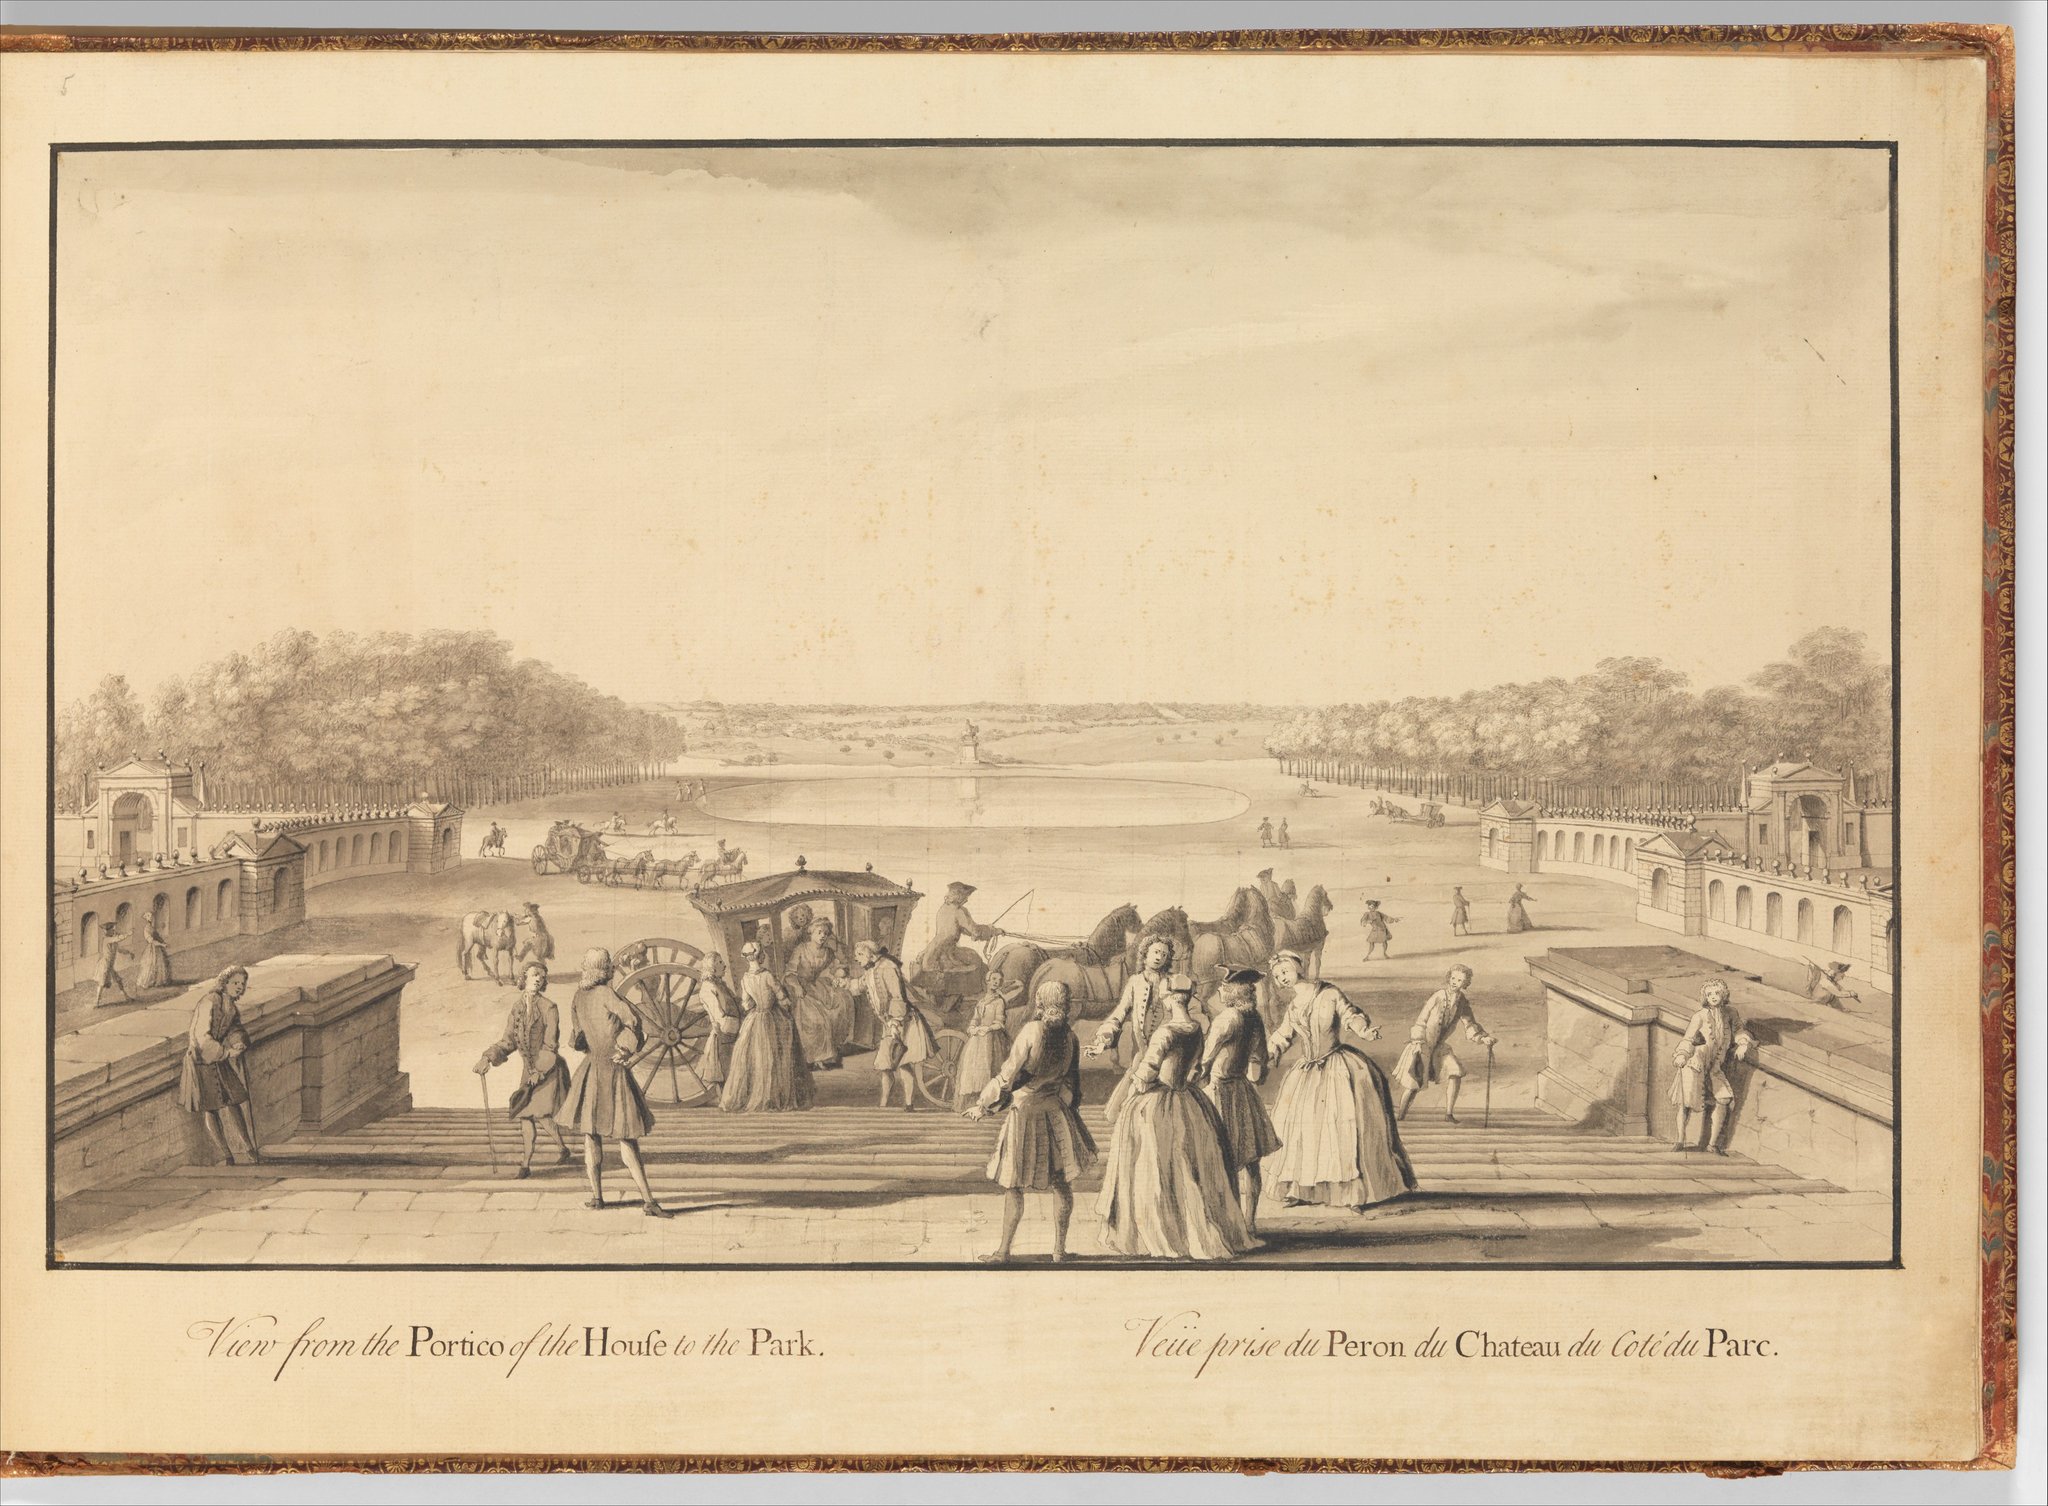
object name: drawing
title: View from the Portico of the House to the Park at Stowe, Buckinghamshire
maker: jacques rigaud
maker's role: artist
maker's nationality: french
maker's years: 1681-1754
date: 1733-1734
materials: ink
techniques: brush, pen, wash